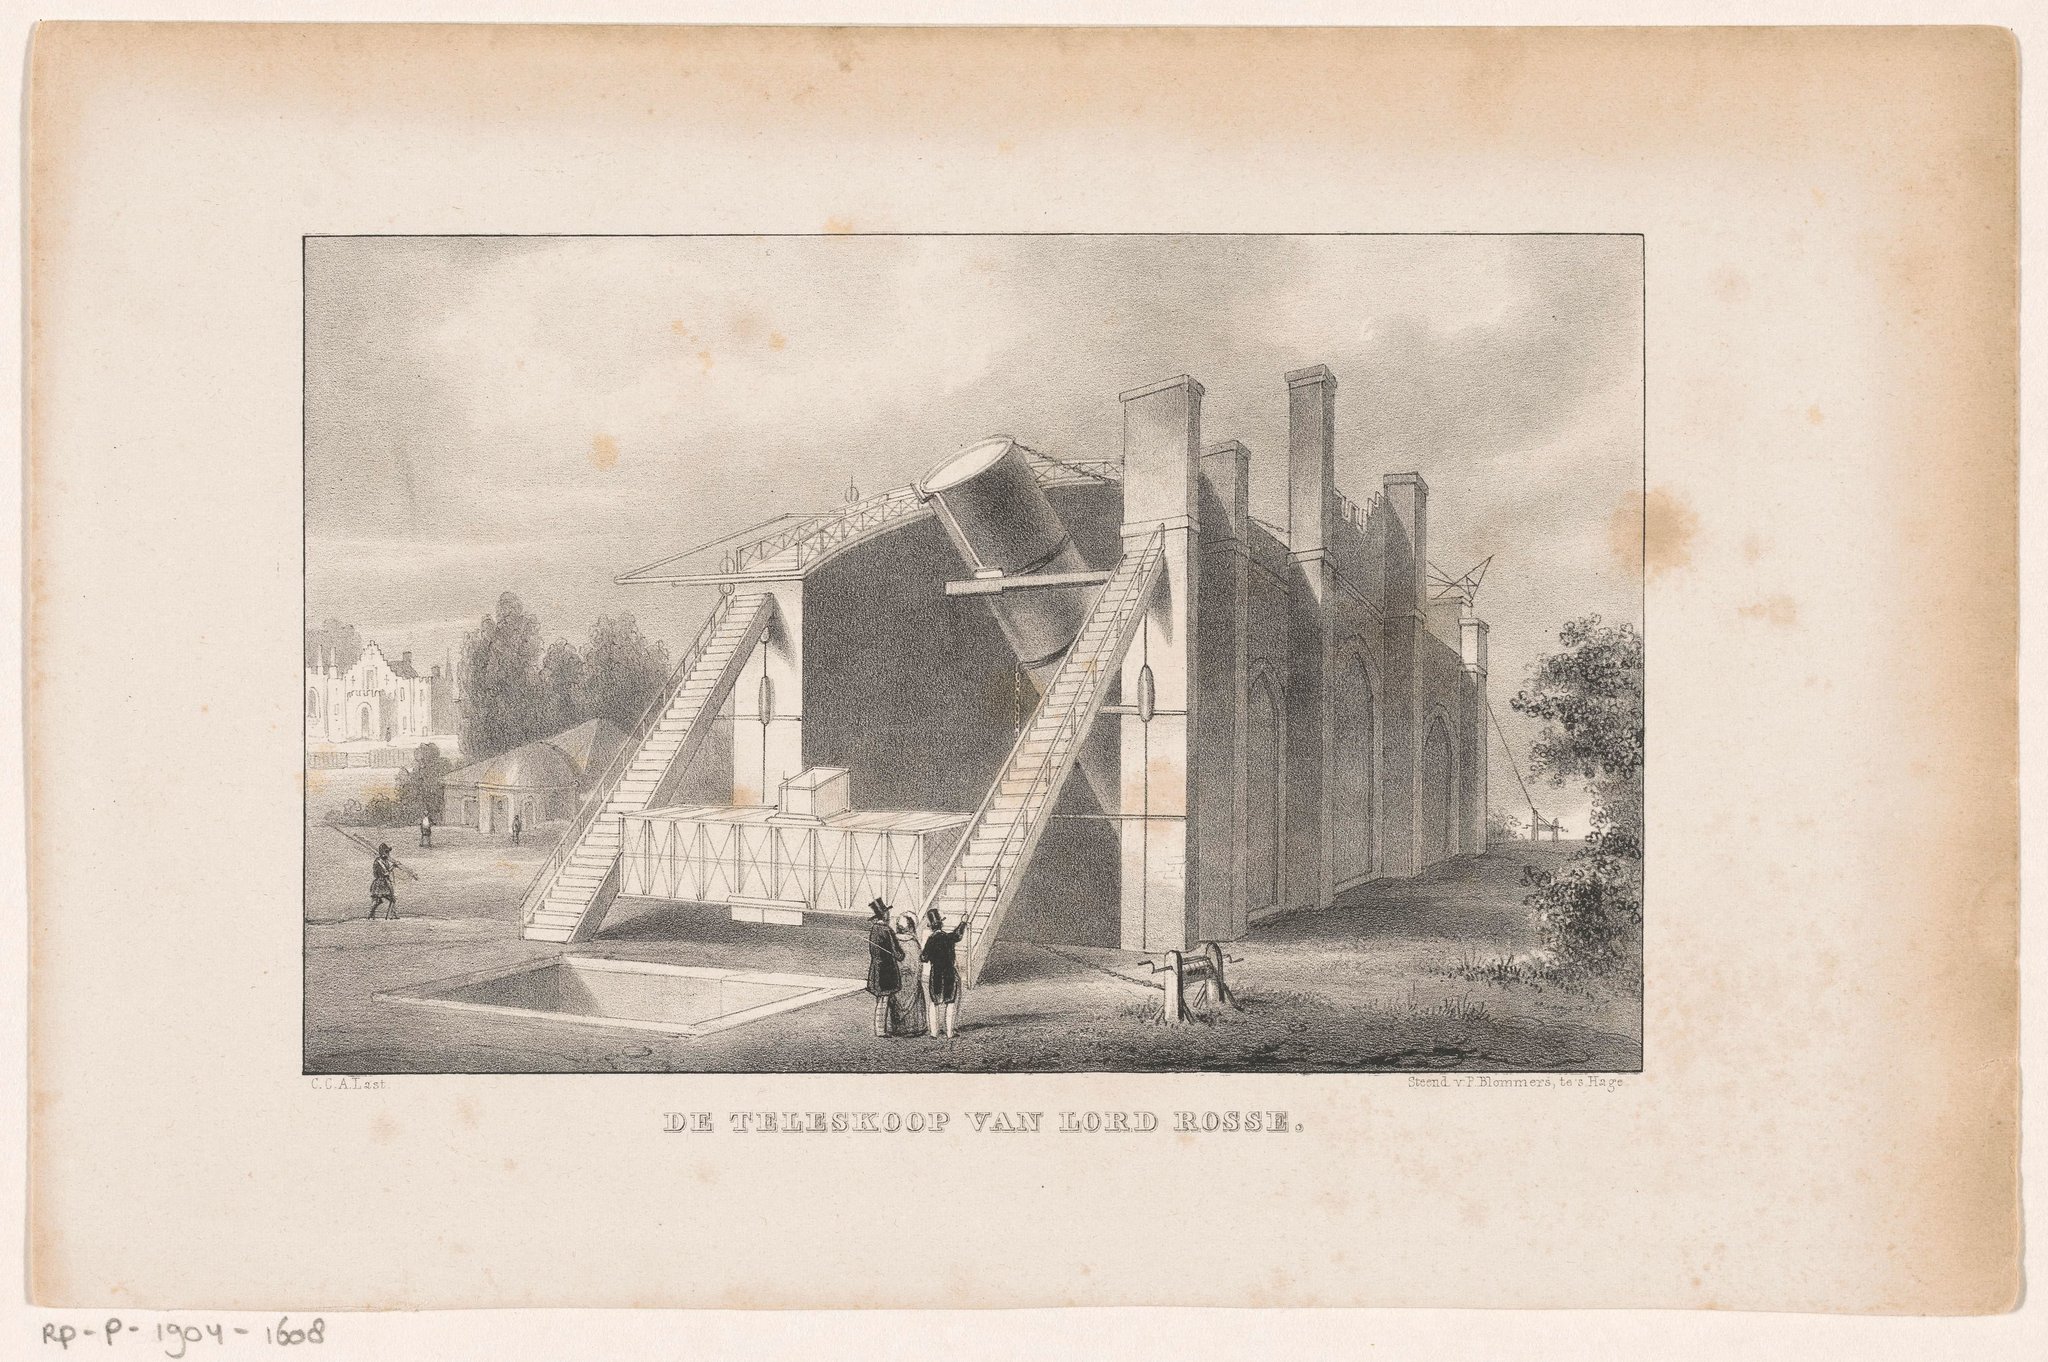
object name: print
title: Telescoop van William Parsons in Ierland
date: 1845-1887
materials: paper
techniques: lithograph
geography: the hague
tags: telescope (+ variant)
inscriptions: collector's mark: Lugt 2228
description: Enkele figuren staan ernaast en bekijken de telescoop.